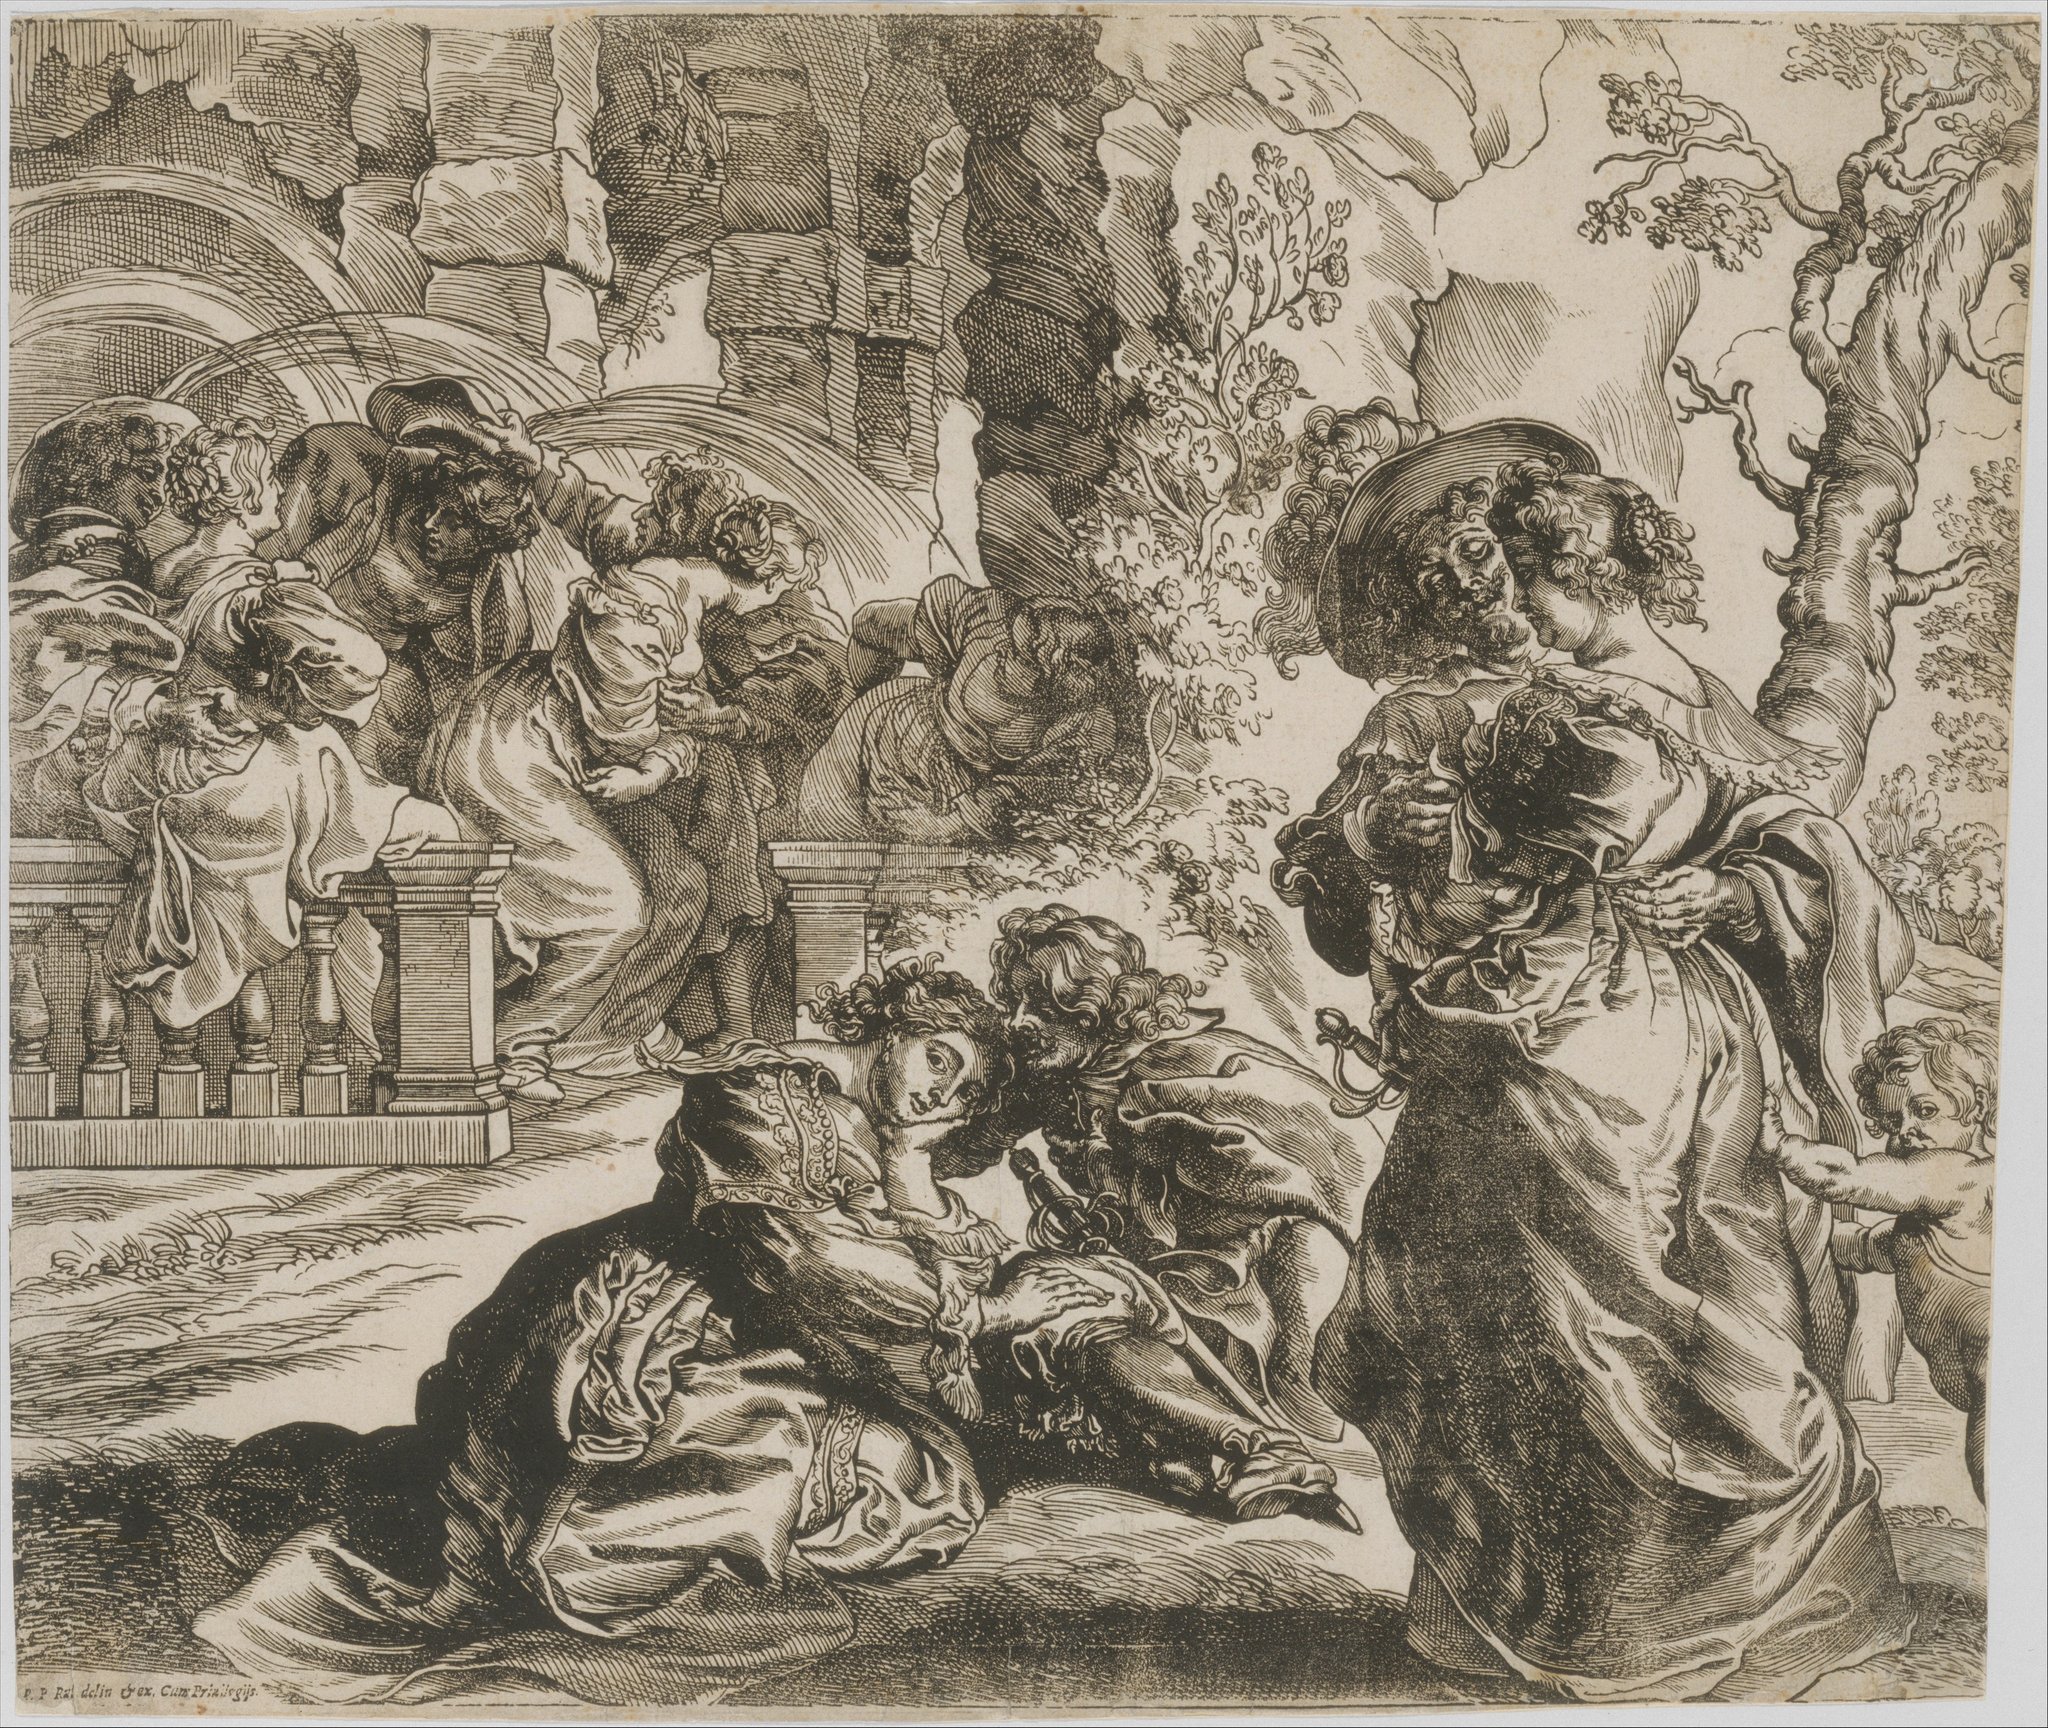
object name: print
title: The Garden of Love (right block)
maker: christoffel jegher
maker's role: artist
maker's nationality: flemish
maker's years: 1596-1653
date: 1630-1639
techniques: woodcut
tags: couples,men,women